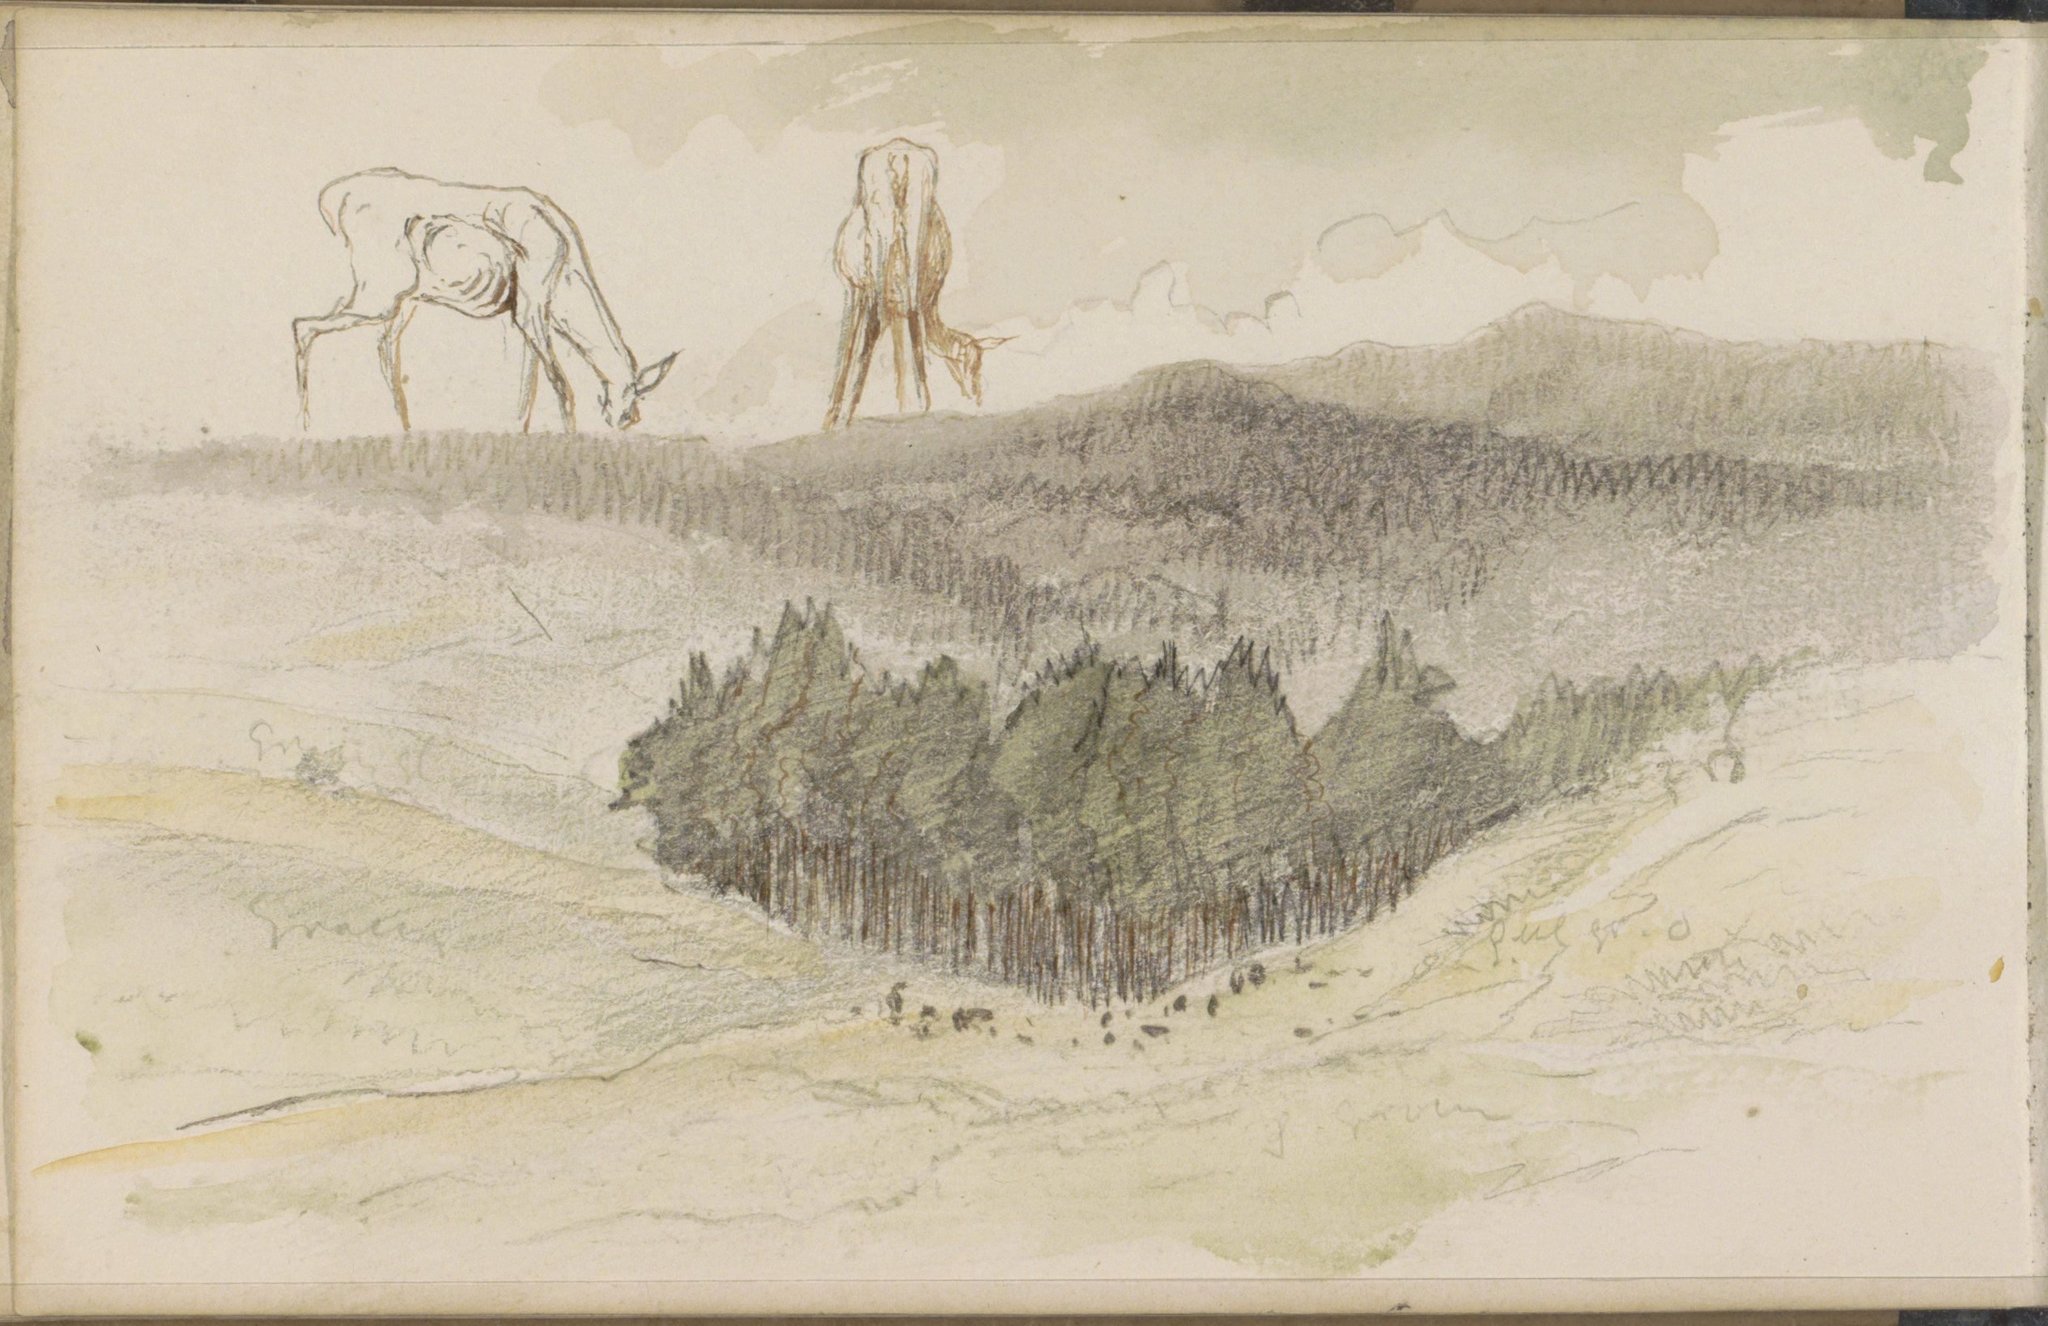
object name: sketchbook leaf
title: Bos in een dal en grazende herten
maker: johannes tavenraat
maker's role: draughtsman, painter, print maker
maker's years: 1809-1881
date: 1808-1869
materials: ink, paper, pencil, watercolor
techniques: brush, pen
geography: marienbad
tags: dale, valley, hoofed animals: deer, forest, wood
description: Blad 24 verso uit een schetsboek met 48 bladen.